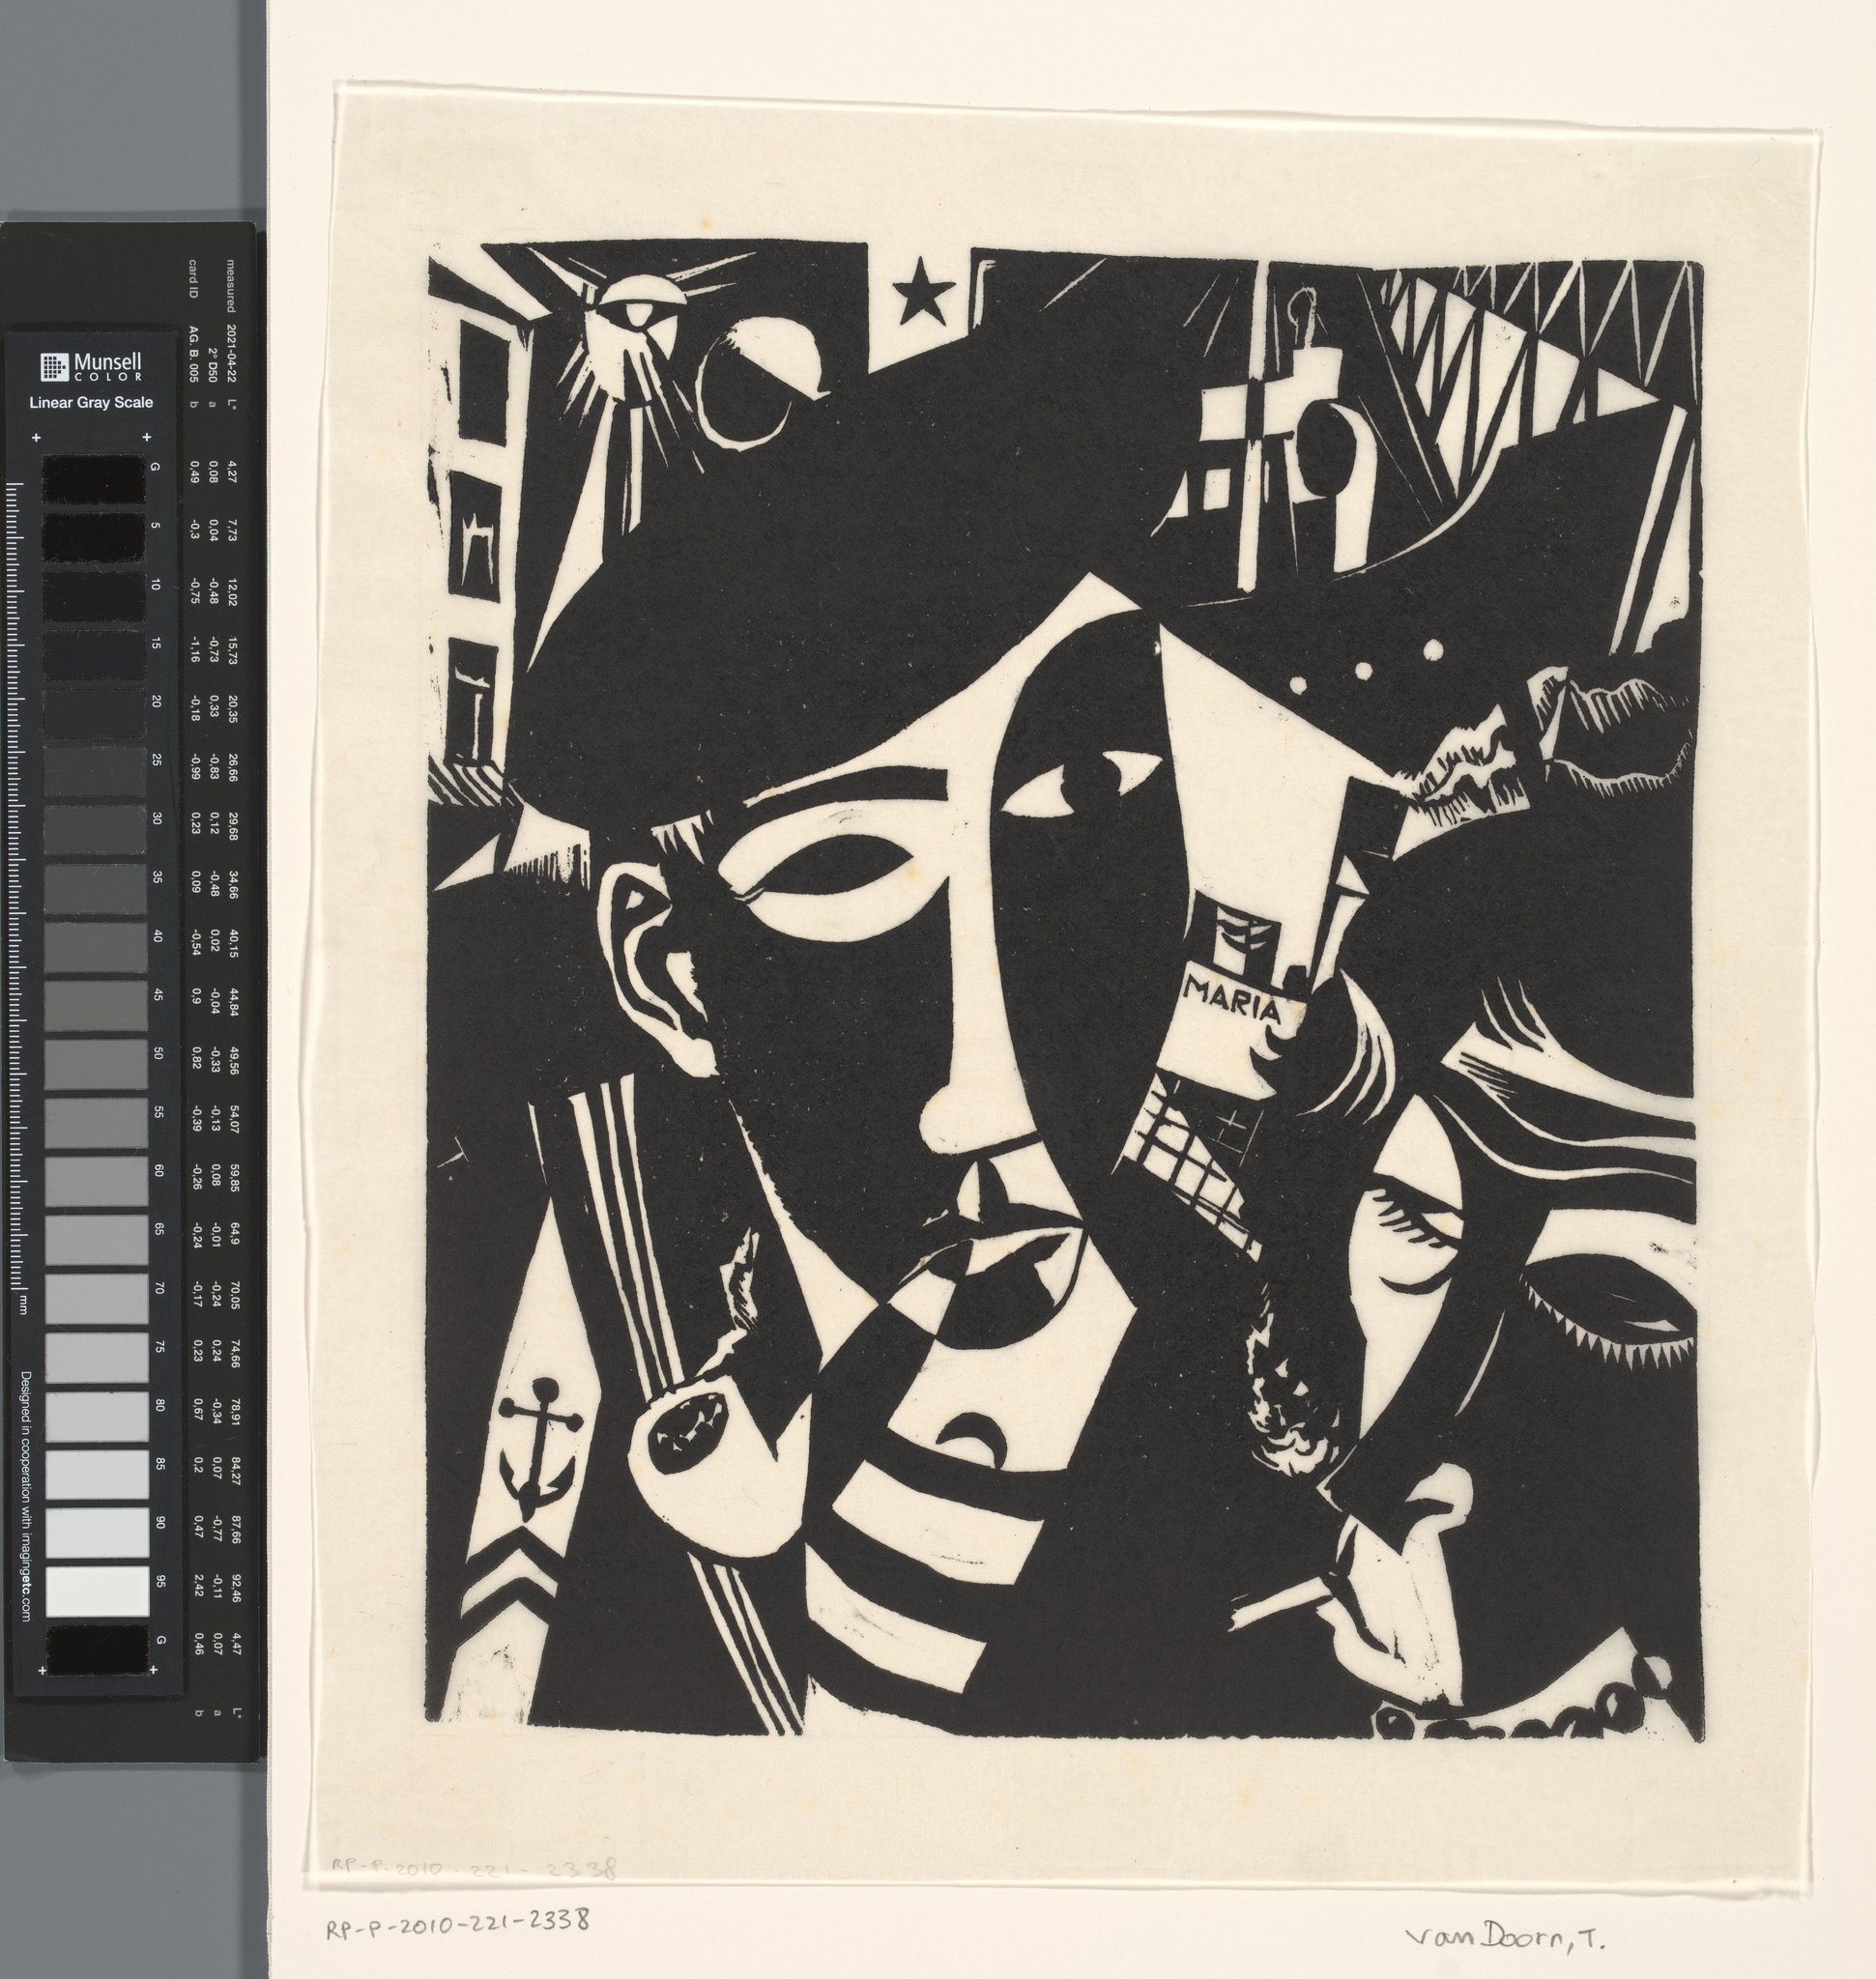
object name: print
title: Passagieren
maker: tinus van doorn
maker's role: painter, print maker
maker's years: 1905-1940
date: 1935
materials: paper, ink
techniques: linocut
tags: passengers ~ ship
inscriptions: inscription: ‘MARIA’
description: Een matroos met een pijp in zijn mond naast een vrouw met een sigaret, gestileerd weergegeven, op de achtergrond een boot en huizen.